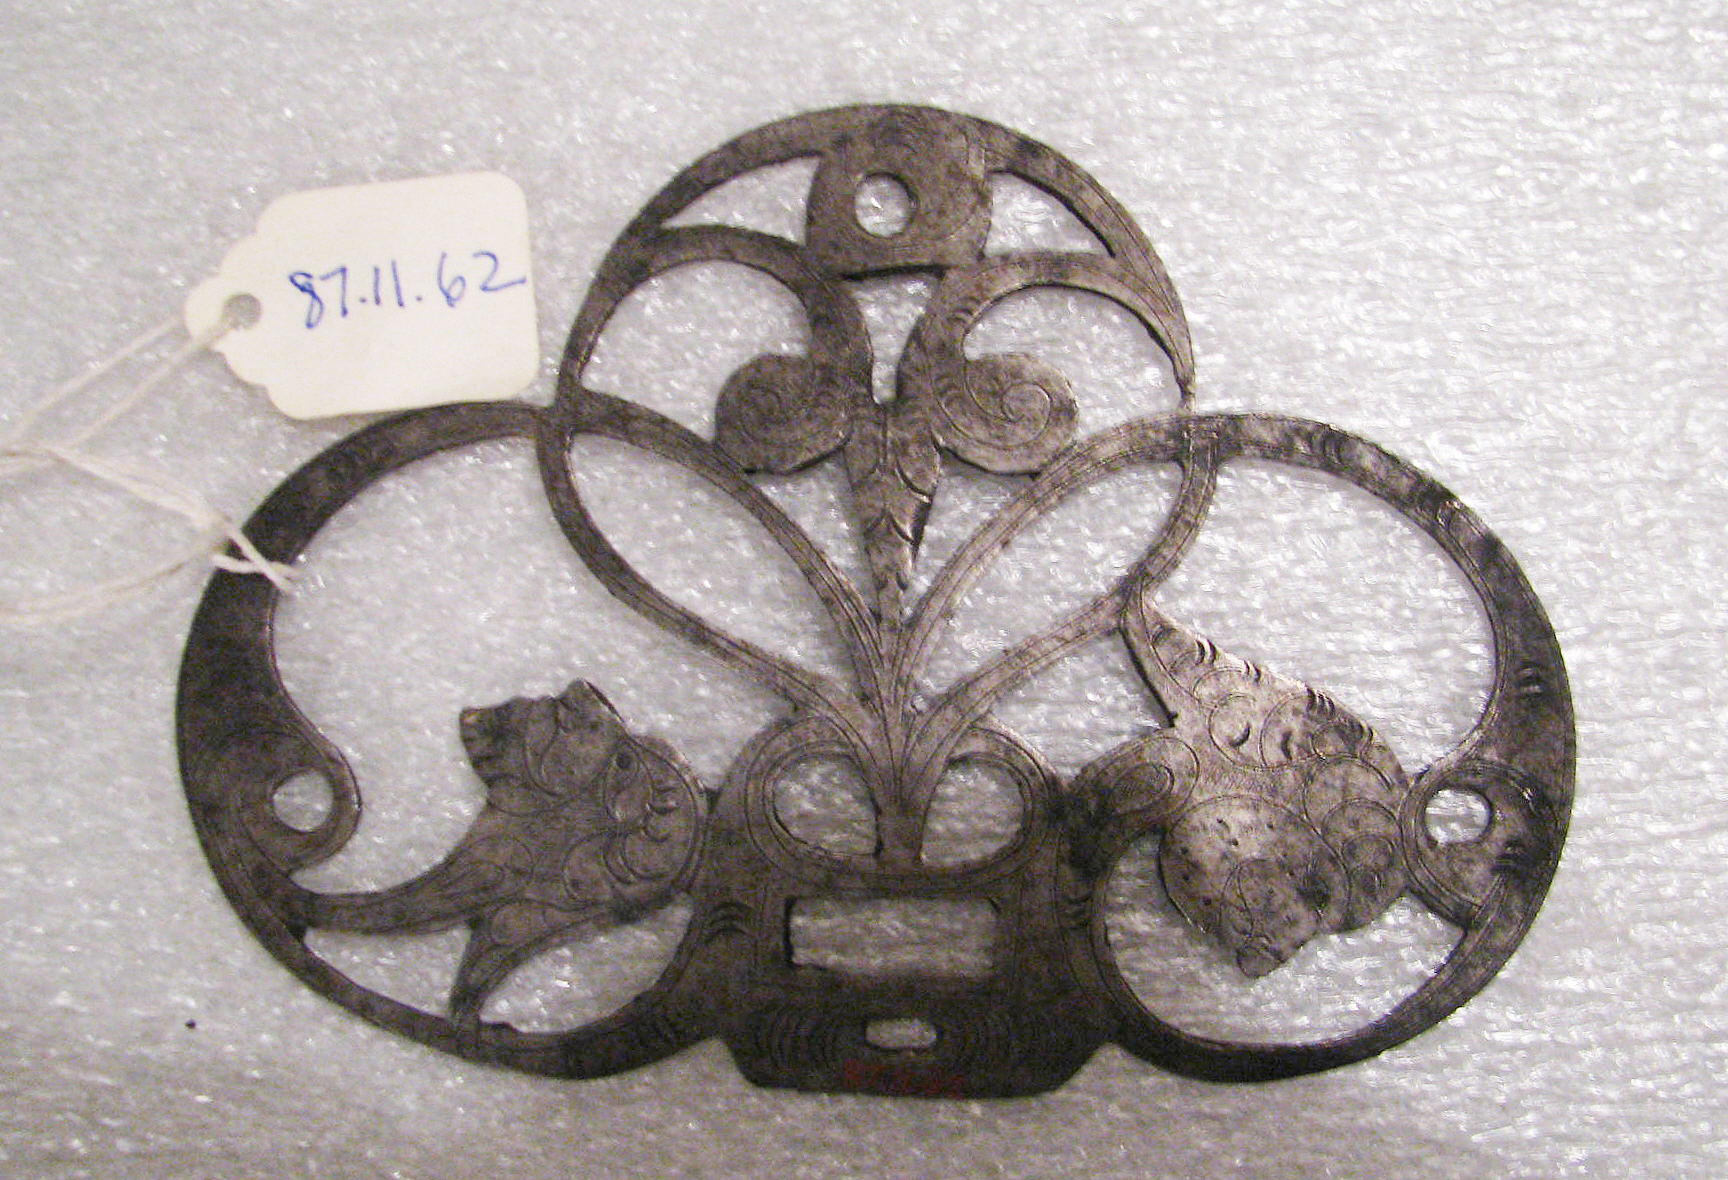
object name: door ornament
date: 1580-1640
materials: iron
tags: profiles